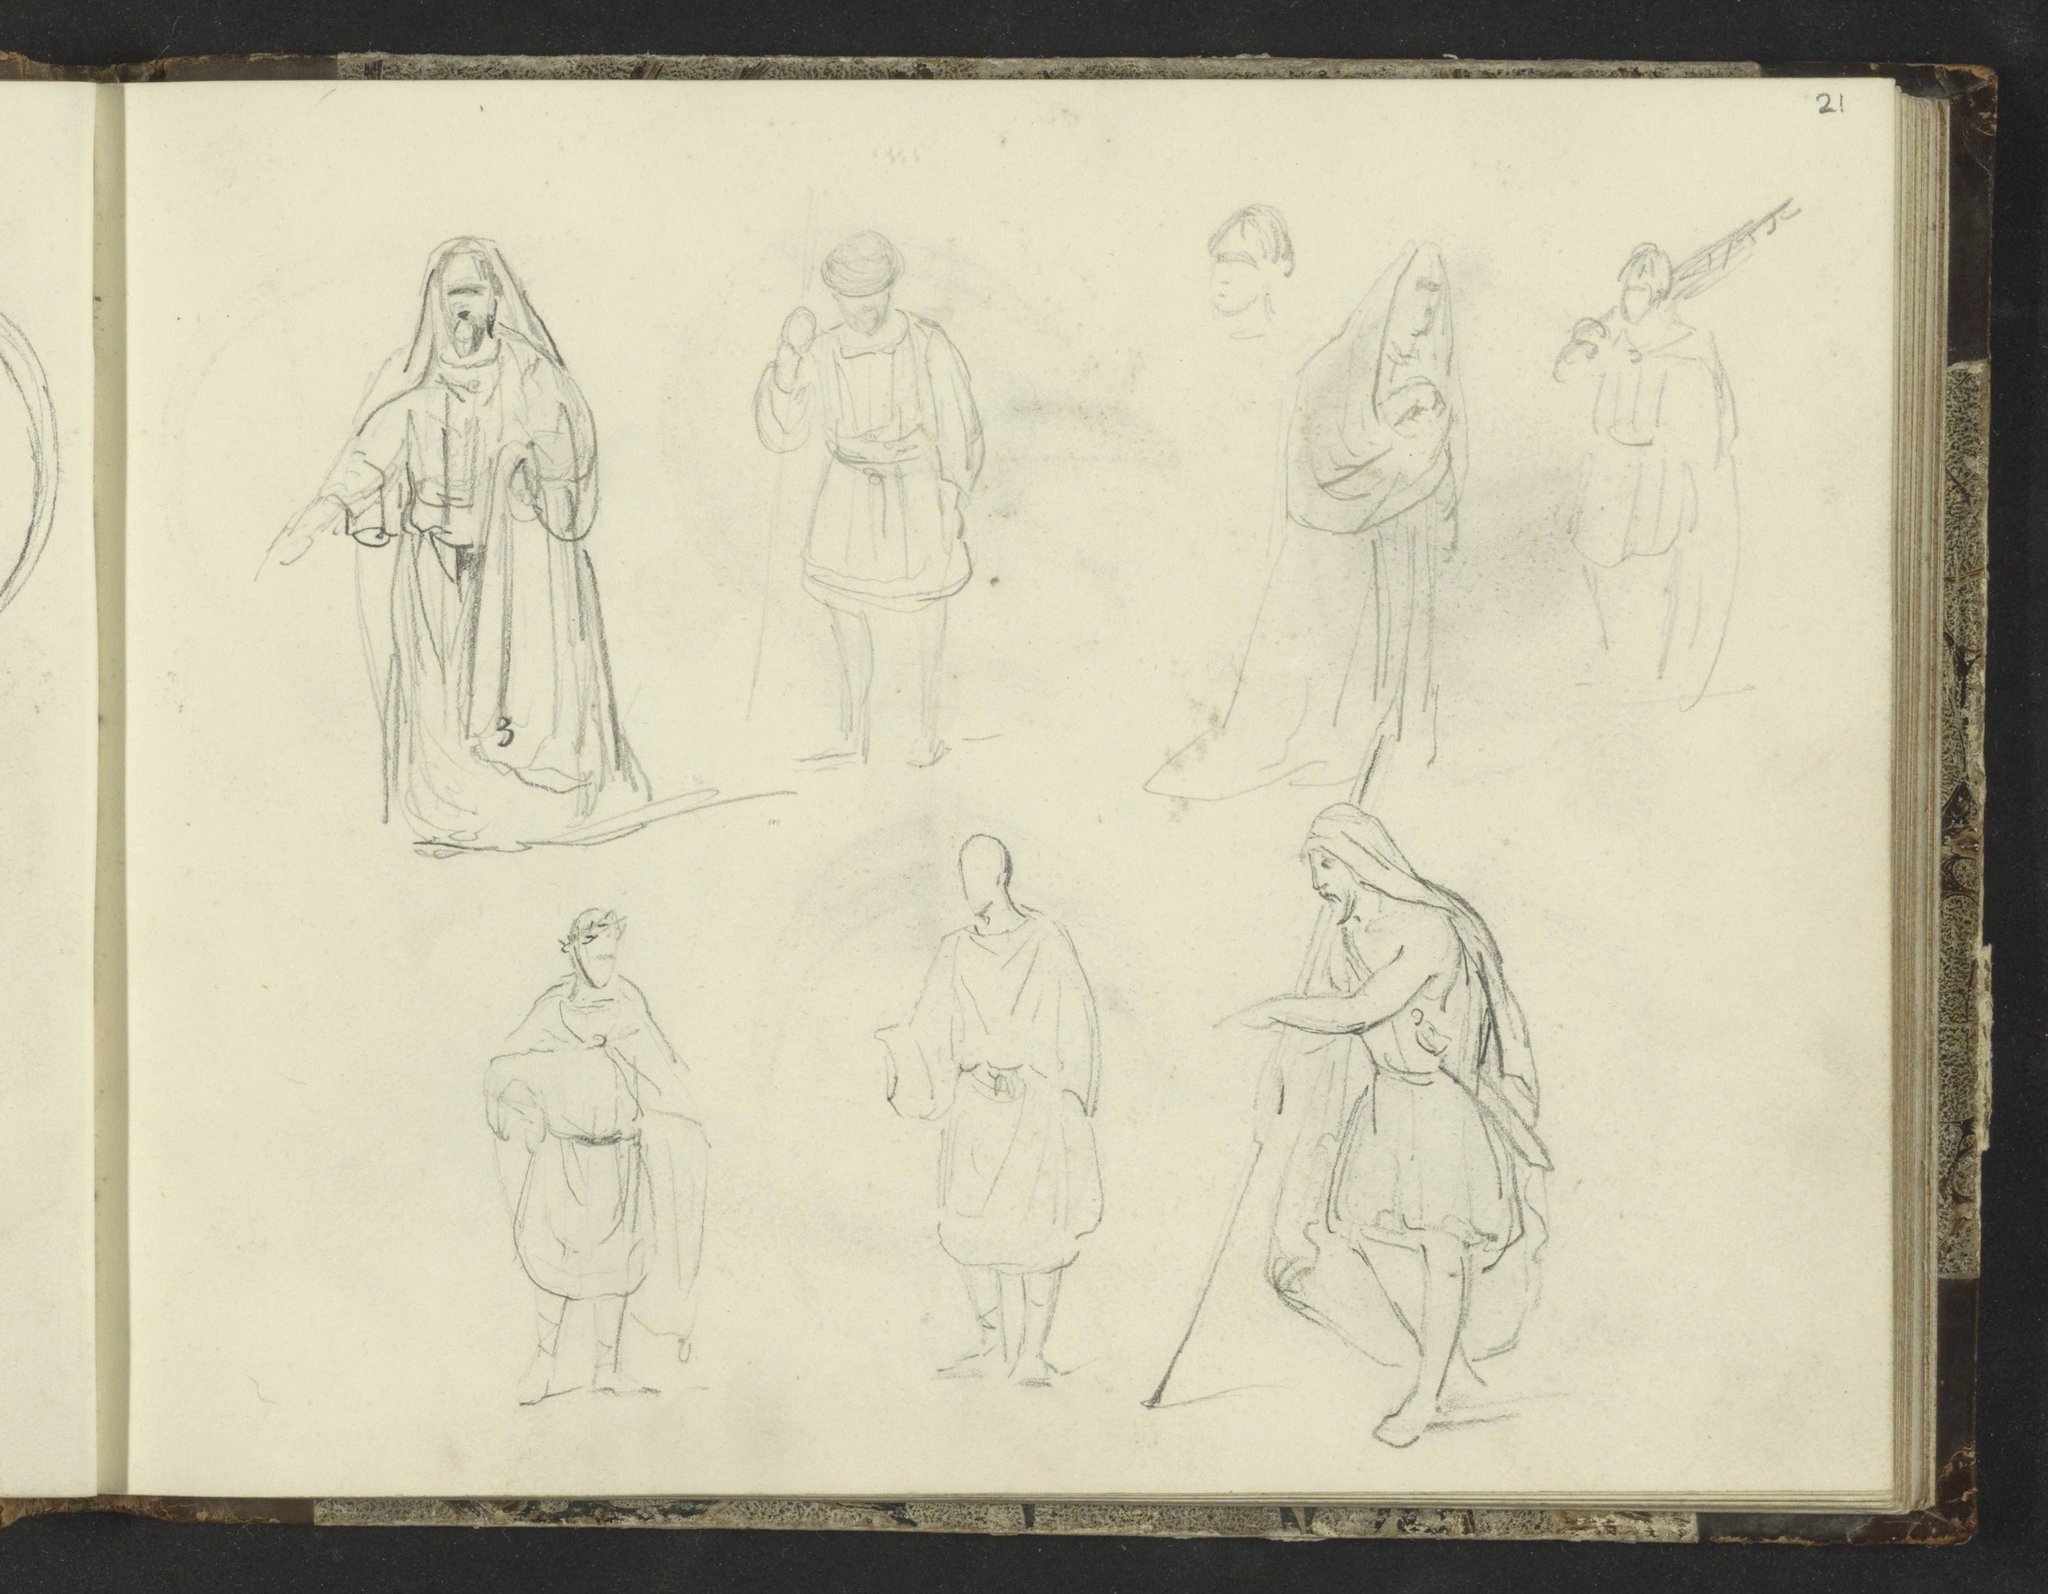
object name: sketchbook leaf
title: Mannen in historisch en religieus kostuum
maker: willem hendrik schmidt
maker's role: draughtsman, painter, print maker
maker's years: 1809-1849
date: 1819-1849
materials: paper, pencil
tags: clothes for special purposes, historical costume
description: Blad 21 recto uit een schetsboek met 58 bladen.